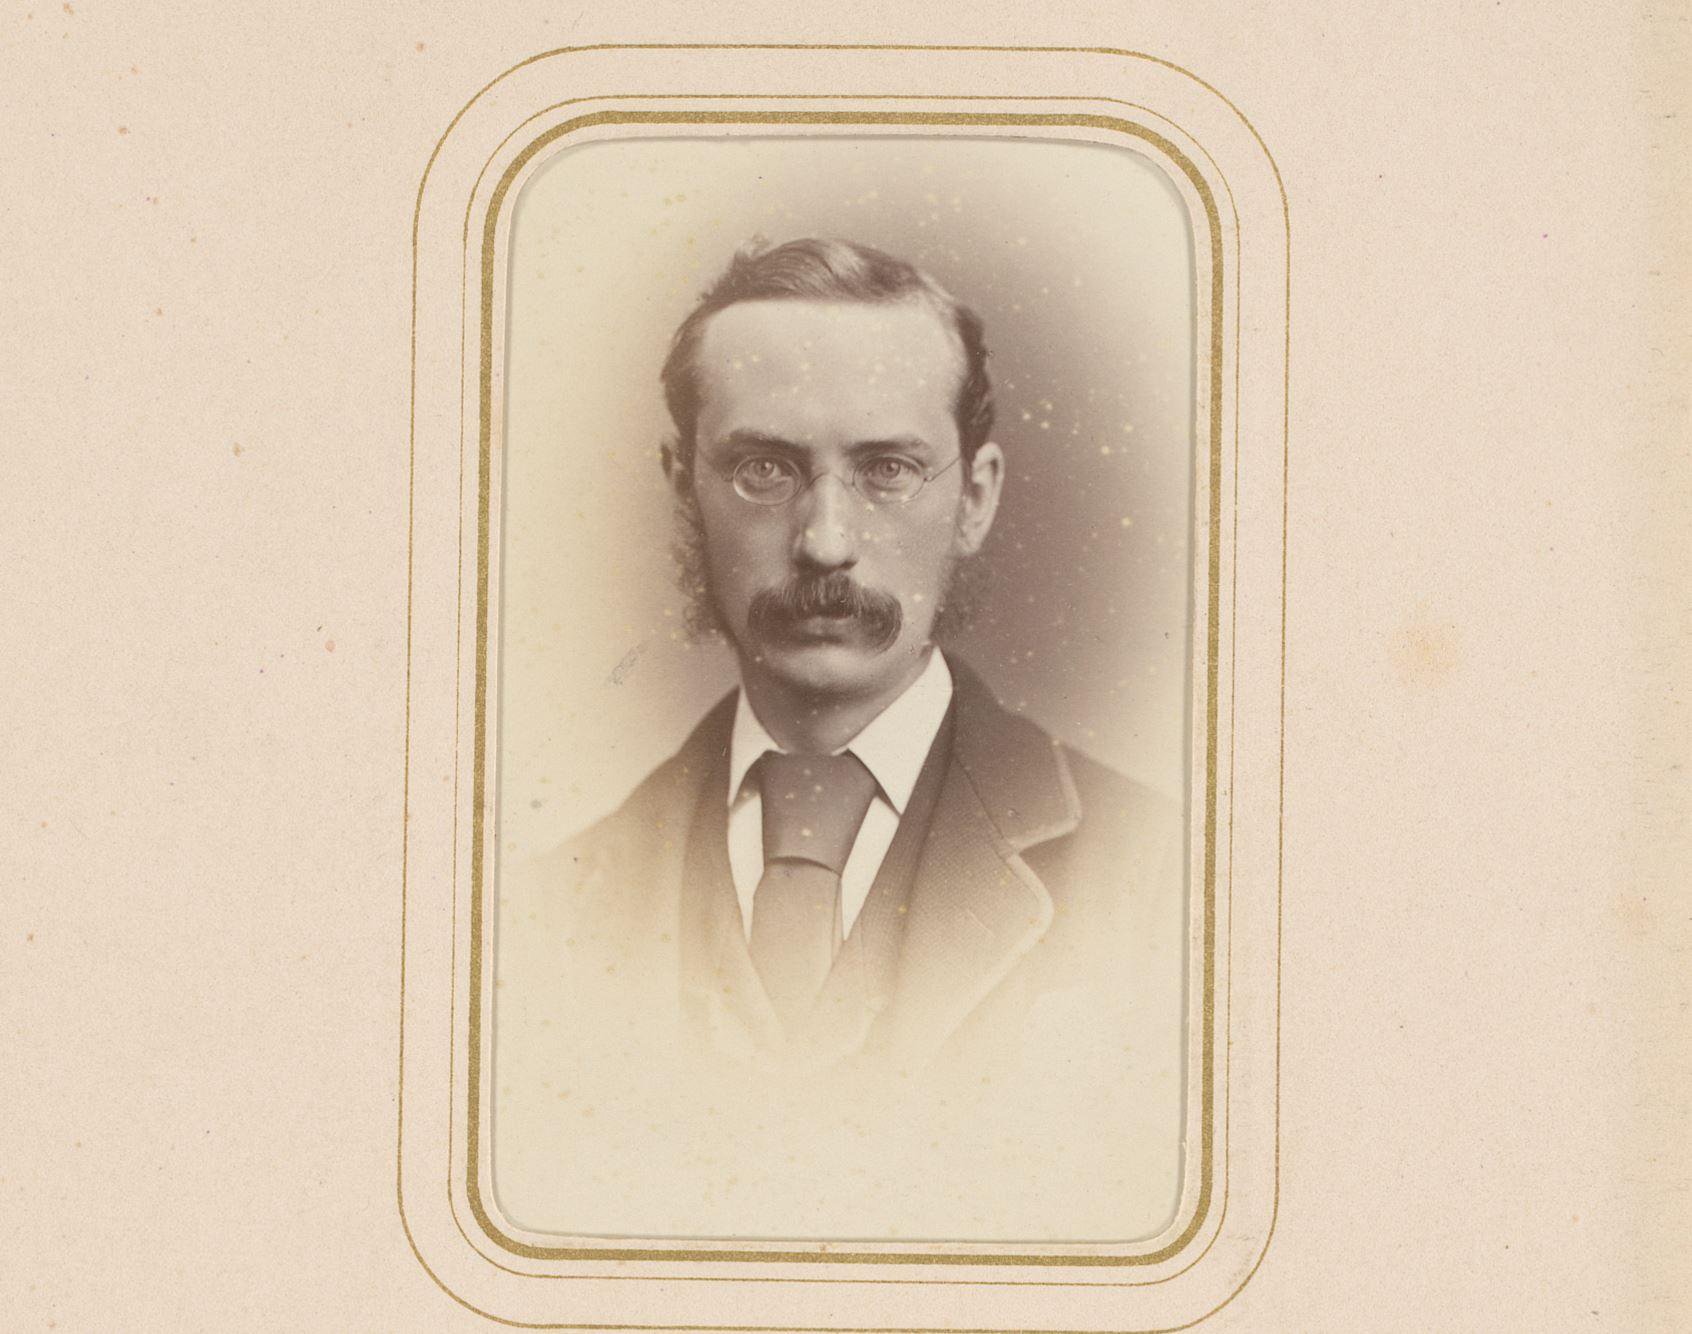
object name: carte de visite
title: Portret van een man met bril en stropdas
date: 1860-1880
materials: cardboard, photographic support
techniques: albumen print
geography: london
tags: eyeglasses, spectacles, historical persons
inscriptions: inscription: ‘Elliott & Fry/ 55, Baker Street,/ Portman Square,/ London./ w./ No. 77663’